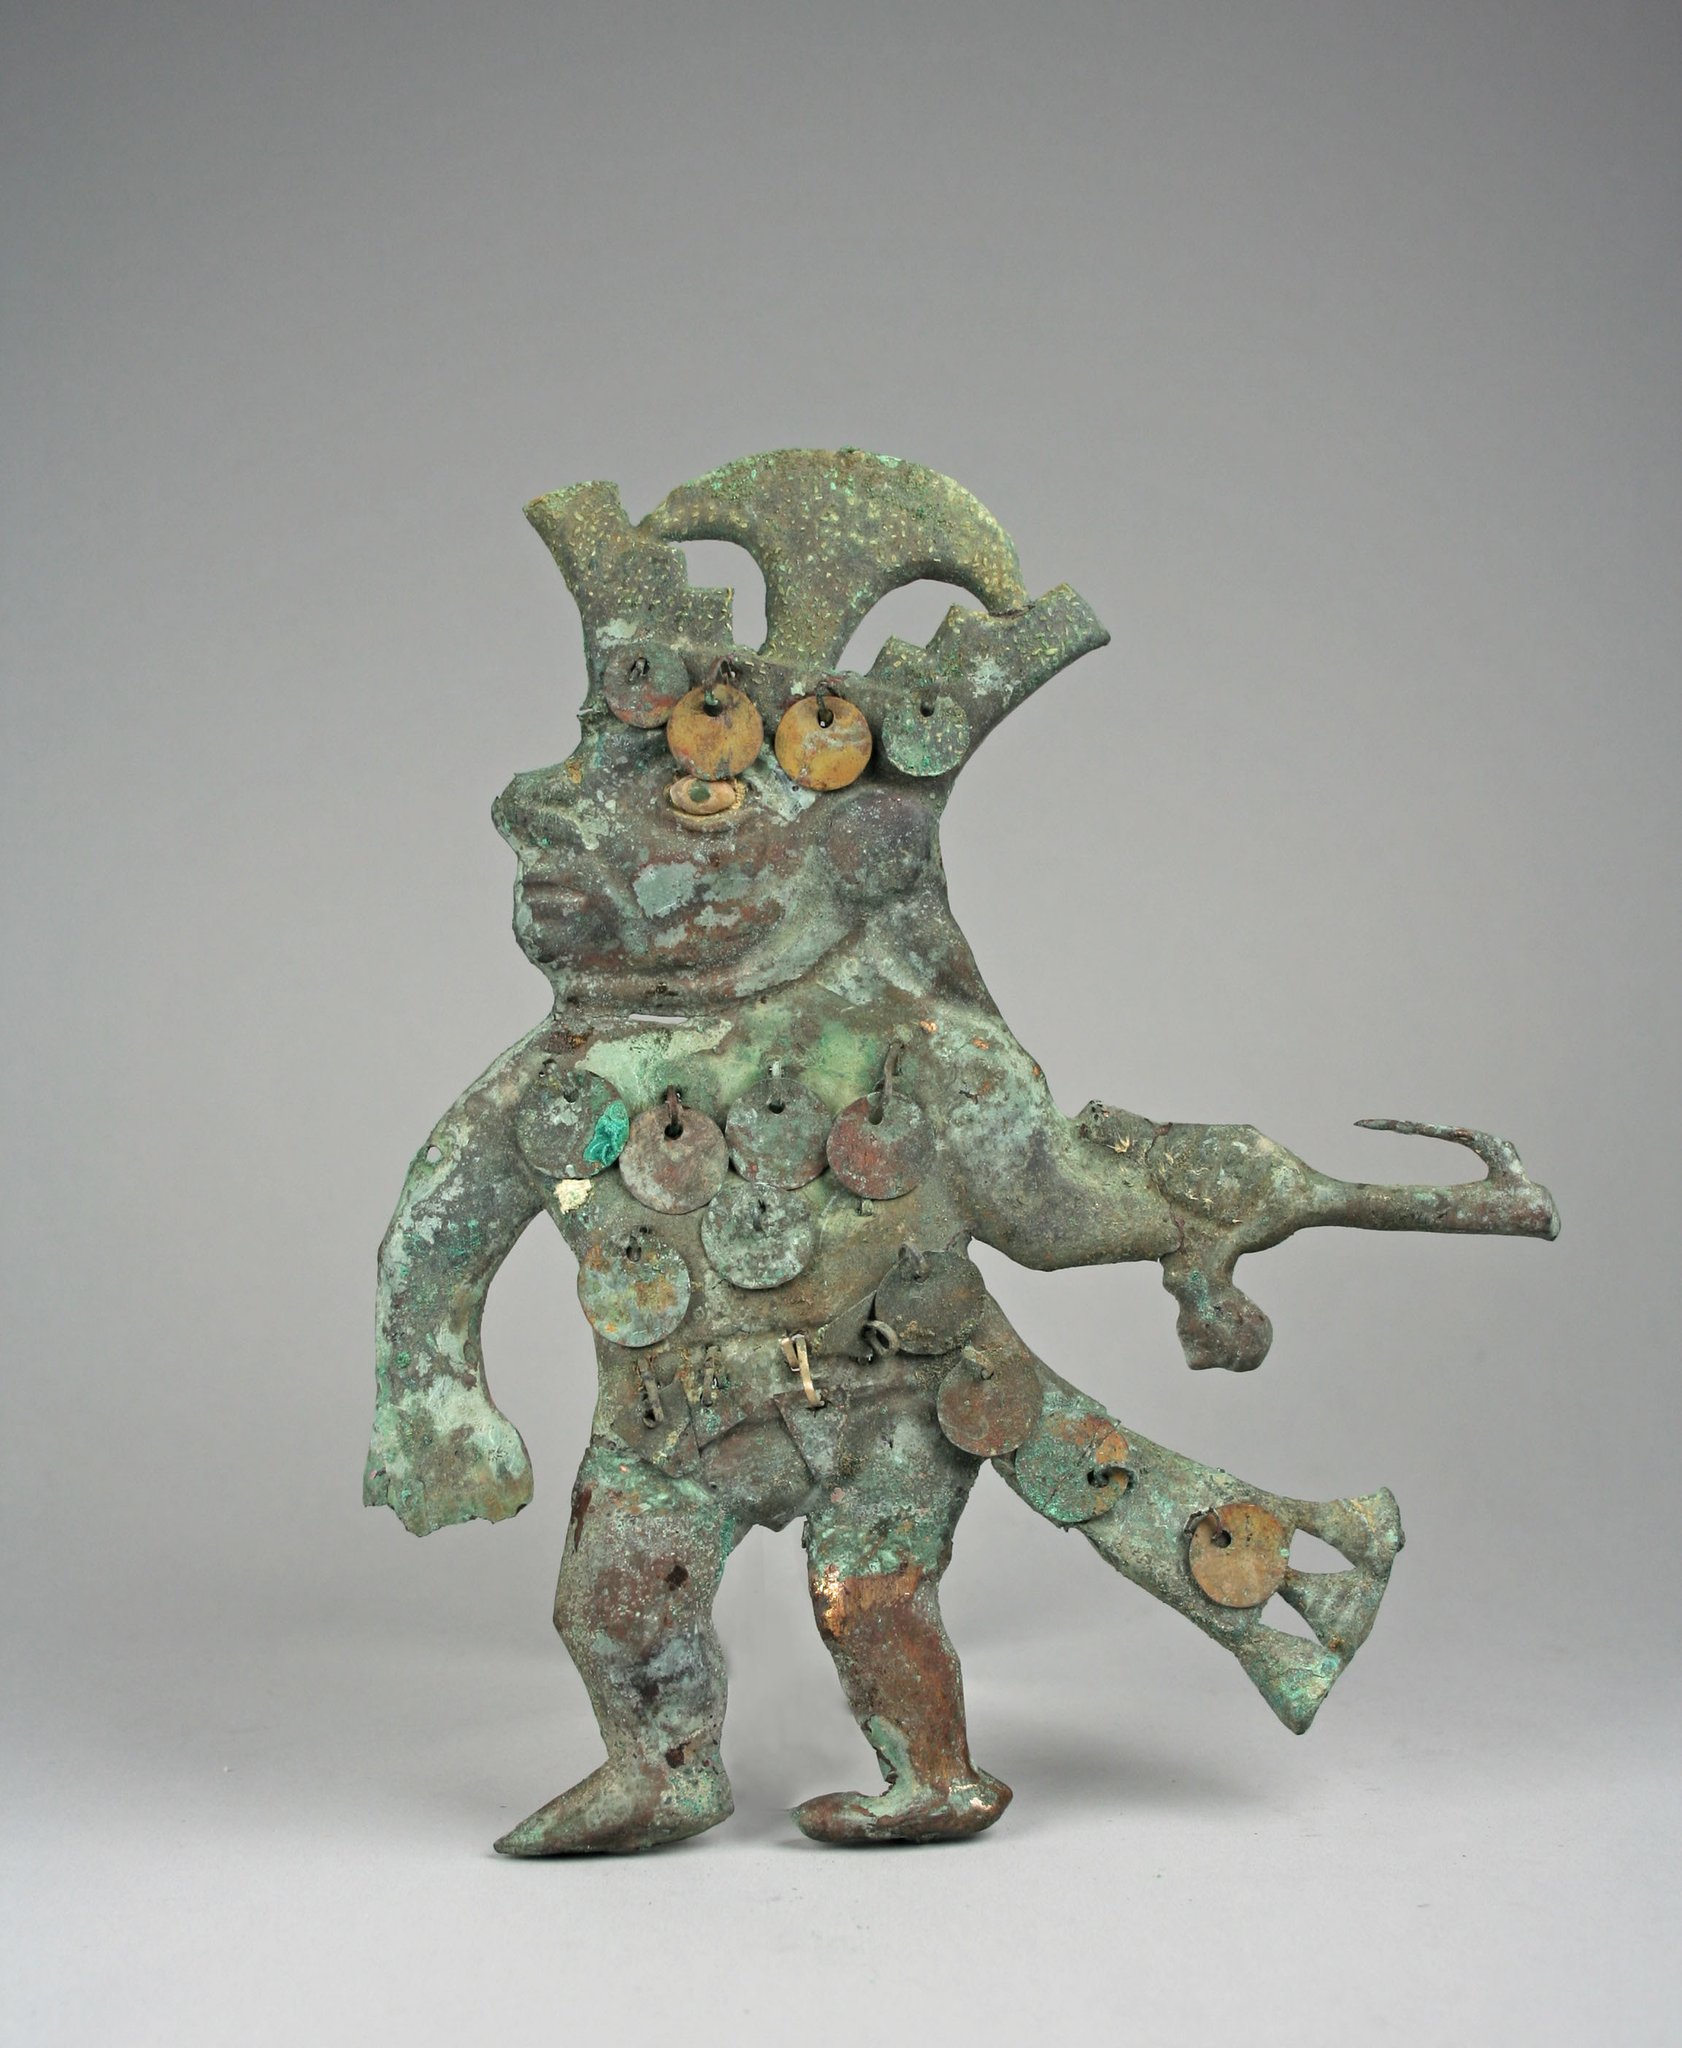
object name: ornament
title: Profile Warrior Ornament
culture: moche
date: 501-700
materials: gilt copper, shell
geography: peru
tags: warriors